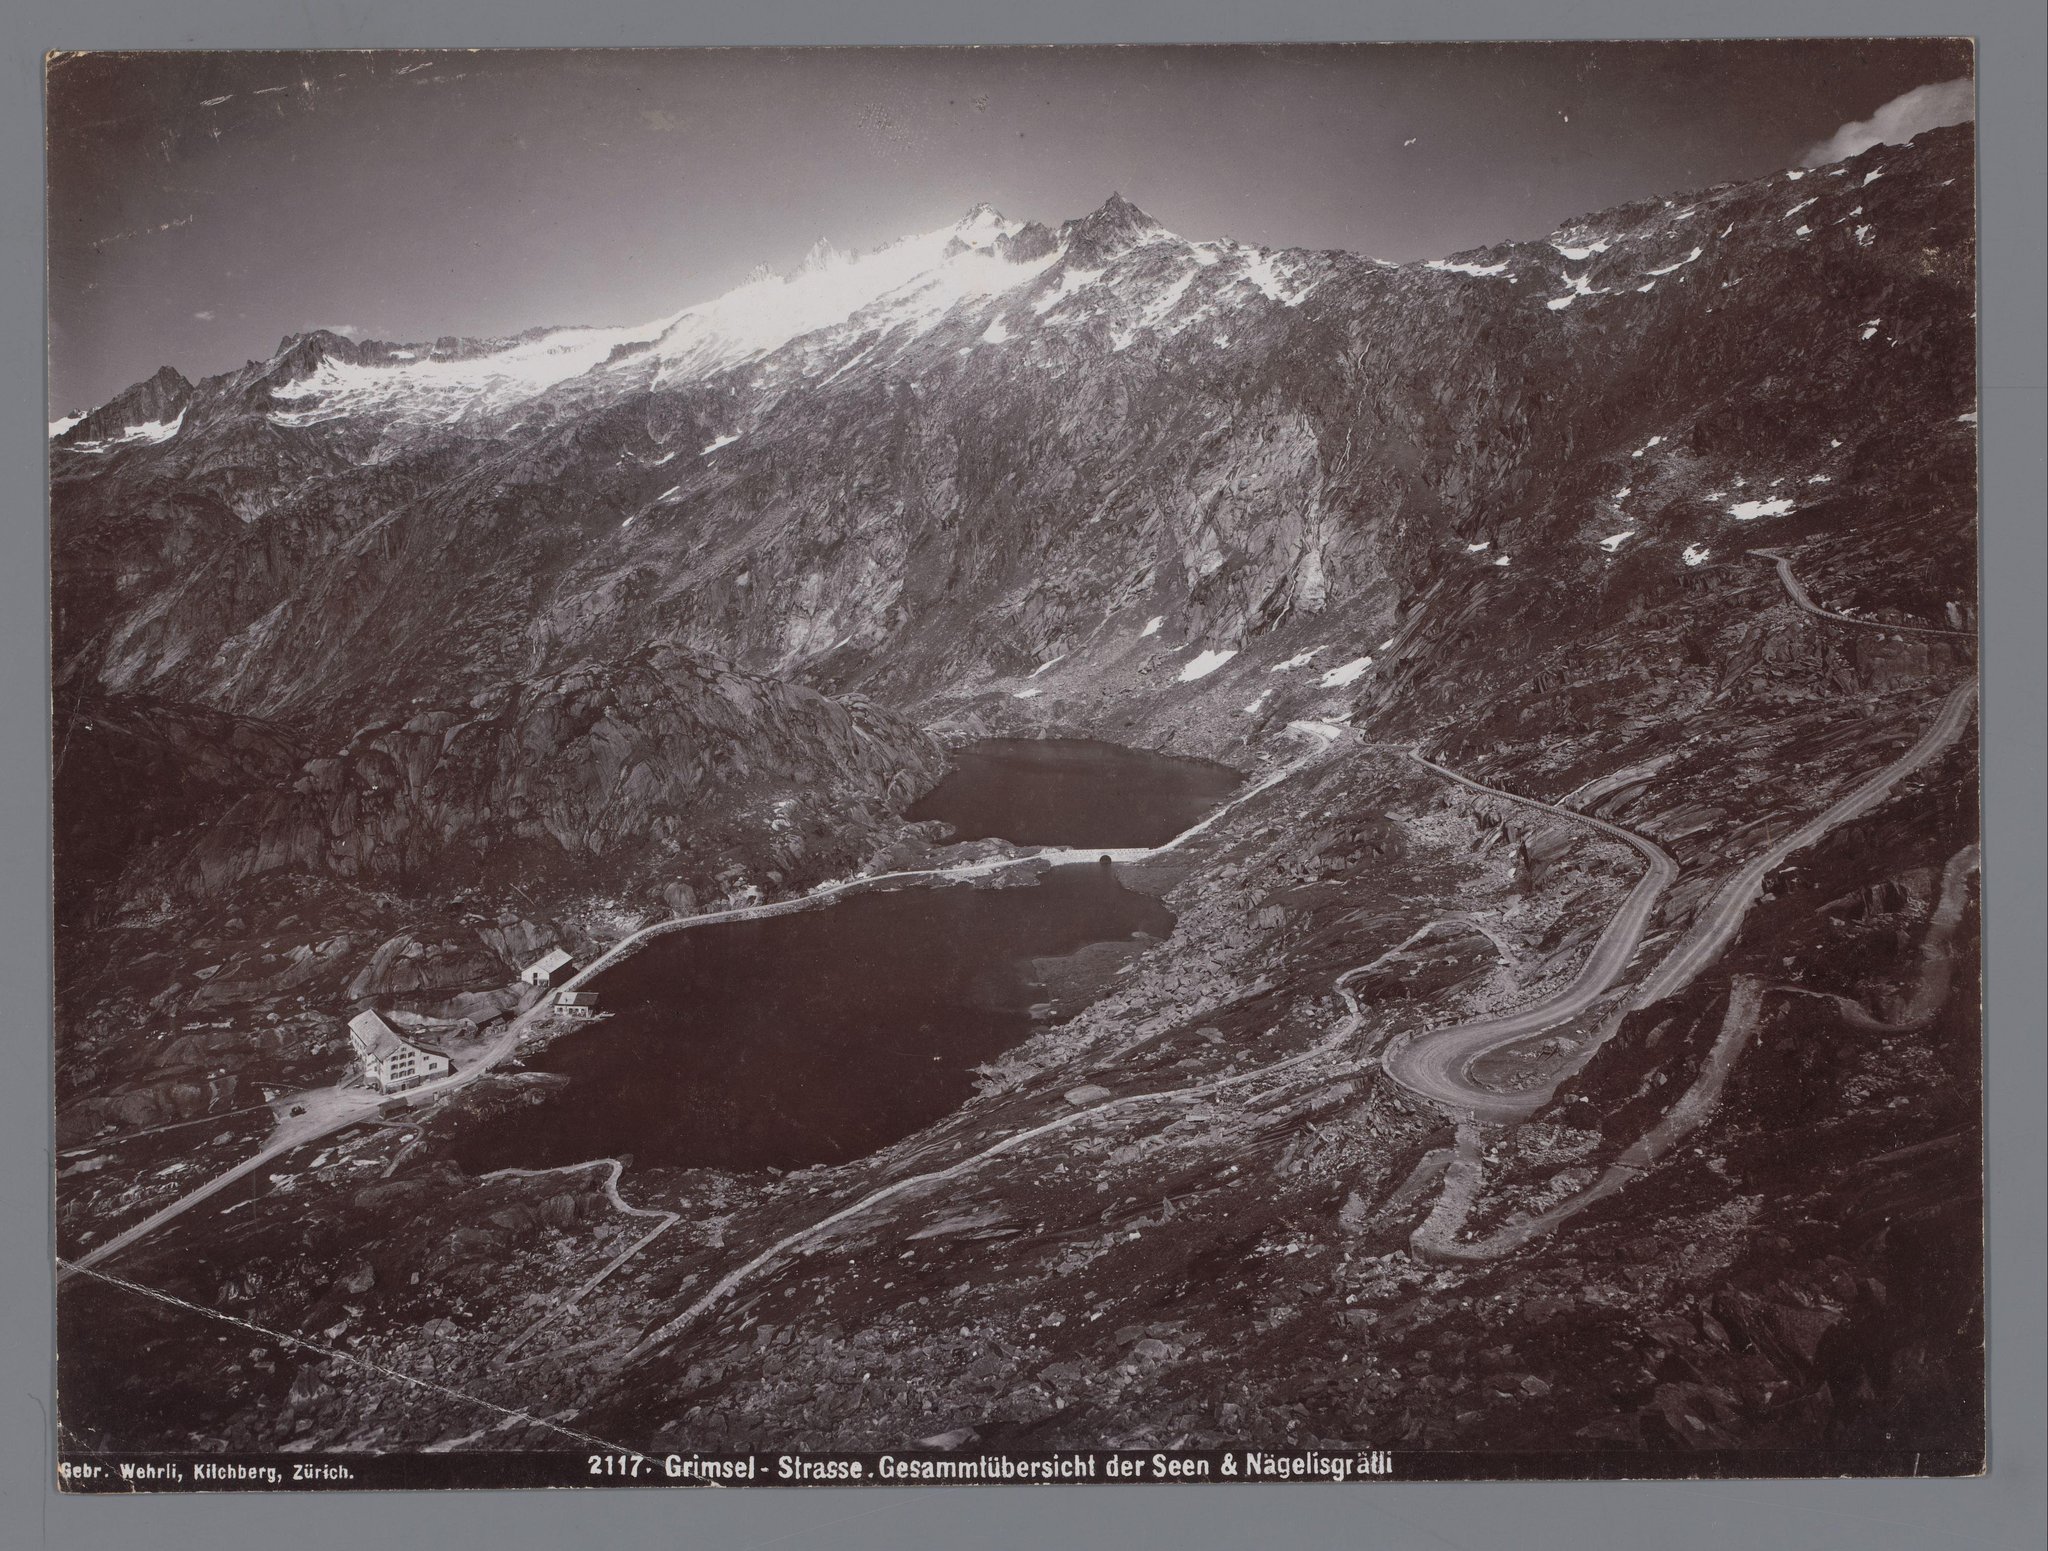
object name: photograph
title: Grimselstrasse, Grimselsee, Räterichbodensee en gebergte Nägelisgrätli , Berner Oberland, Zwitserland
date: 1900-1920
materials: paper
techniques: gelatin silver print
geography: switzerland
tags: switzerland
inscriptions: inscription: ‘2117. Grimsel - Strasse. Gesammtübersicht der Seen & Nägelisgrätli’, inscription: ‘Gebr. Wehrli, Kilchberg, Zürich.’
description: Grimselstrasse, Grimselsee op de voorgrond en Räterichbodensee daarachter, Gemeinde Guttannen, Berner Oberland, Zwitserland. Op de achtergrond gebergte Nägelisgrätli.